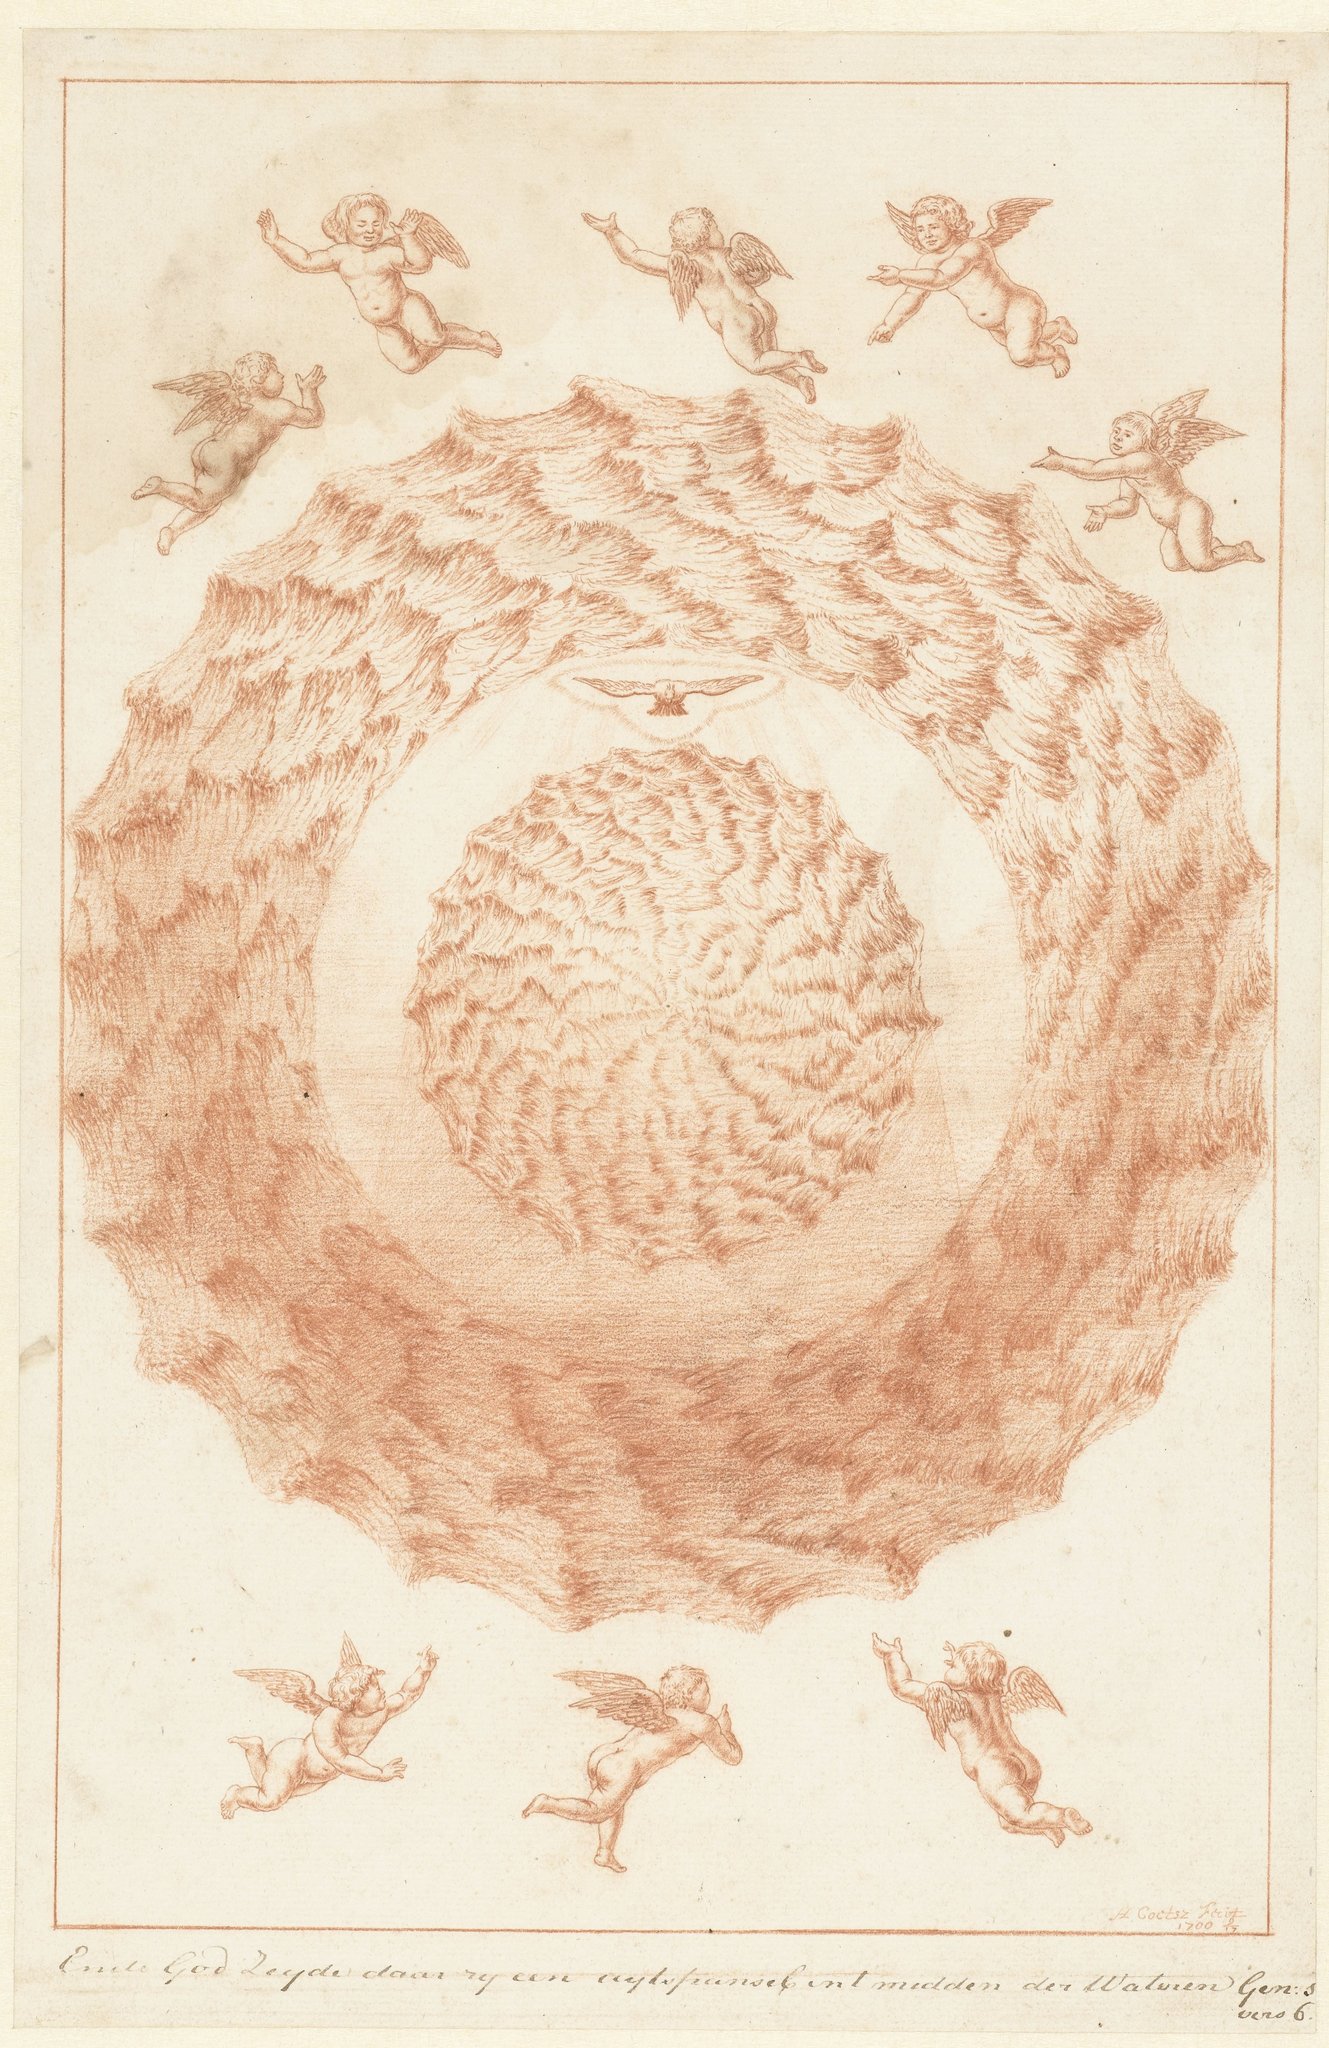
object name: design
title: En God zeide: Daar zij een uitspansel in het midden der wateren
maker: herman coets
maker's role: draughtsman, print maker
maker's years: 1663-1711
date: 1700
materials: chalk, paper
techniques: pouncing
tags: gathering of the waters below the firmament; dry land appears and produces all kinds of plants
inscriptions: date: ‘1700 9/17’